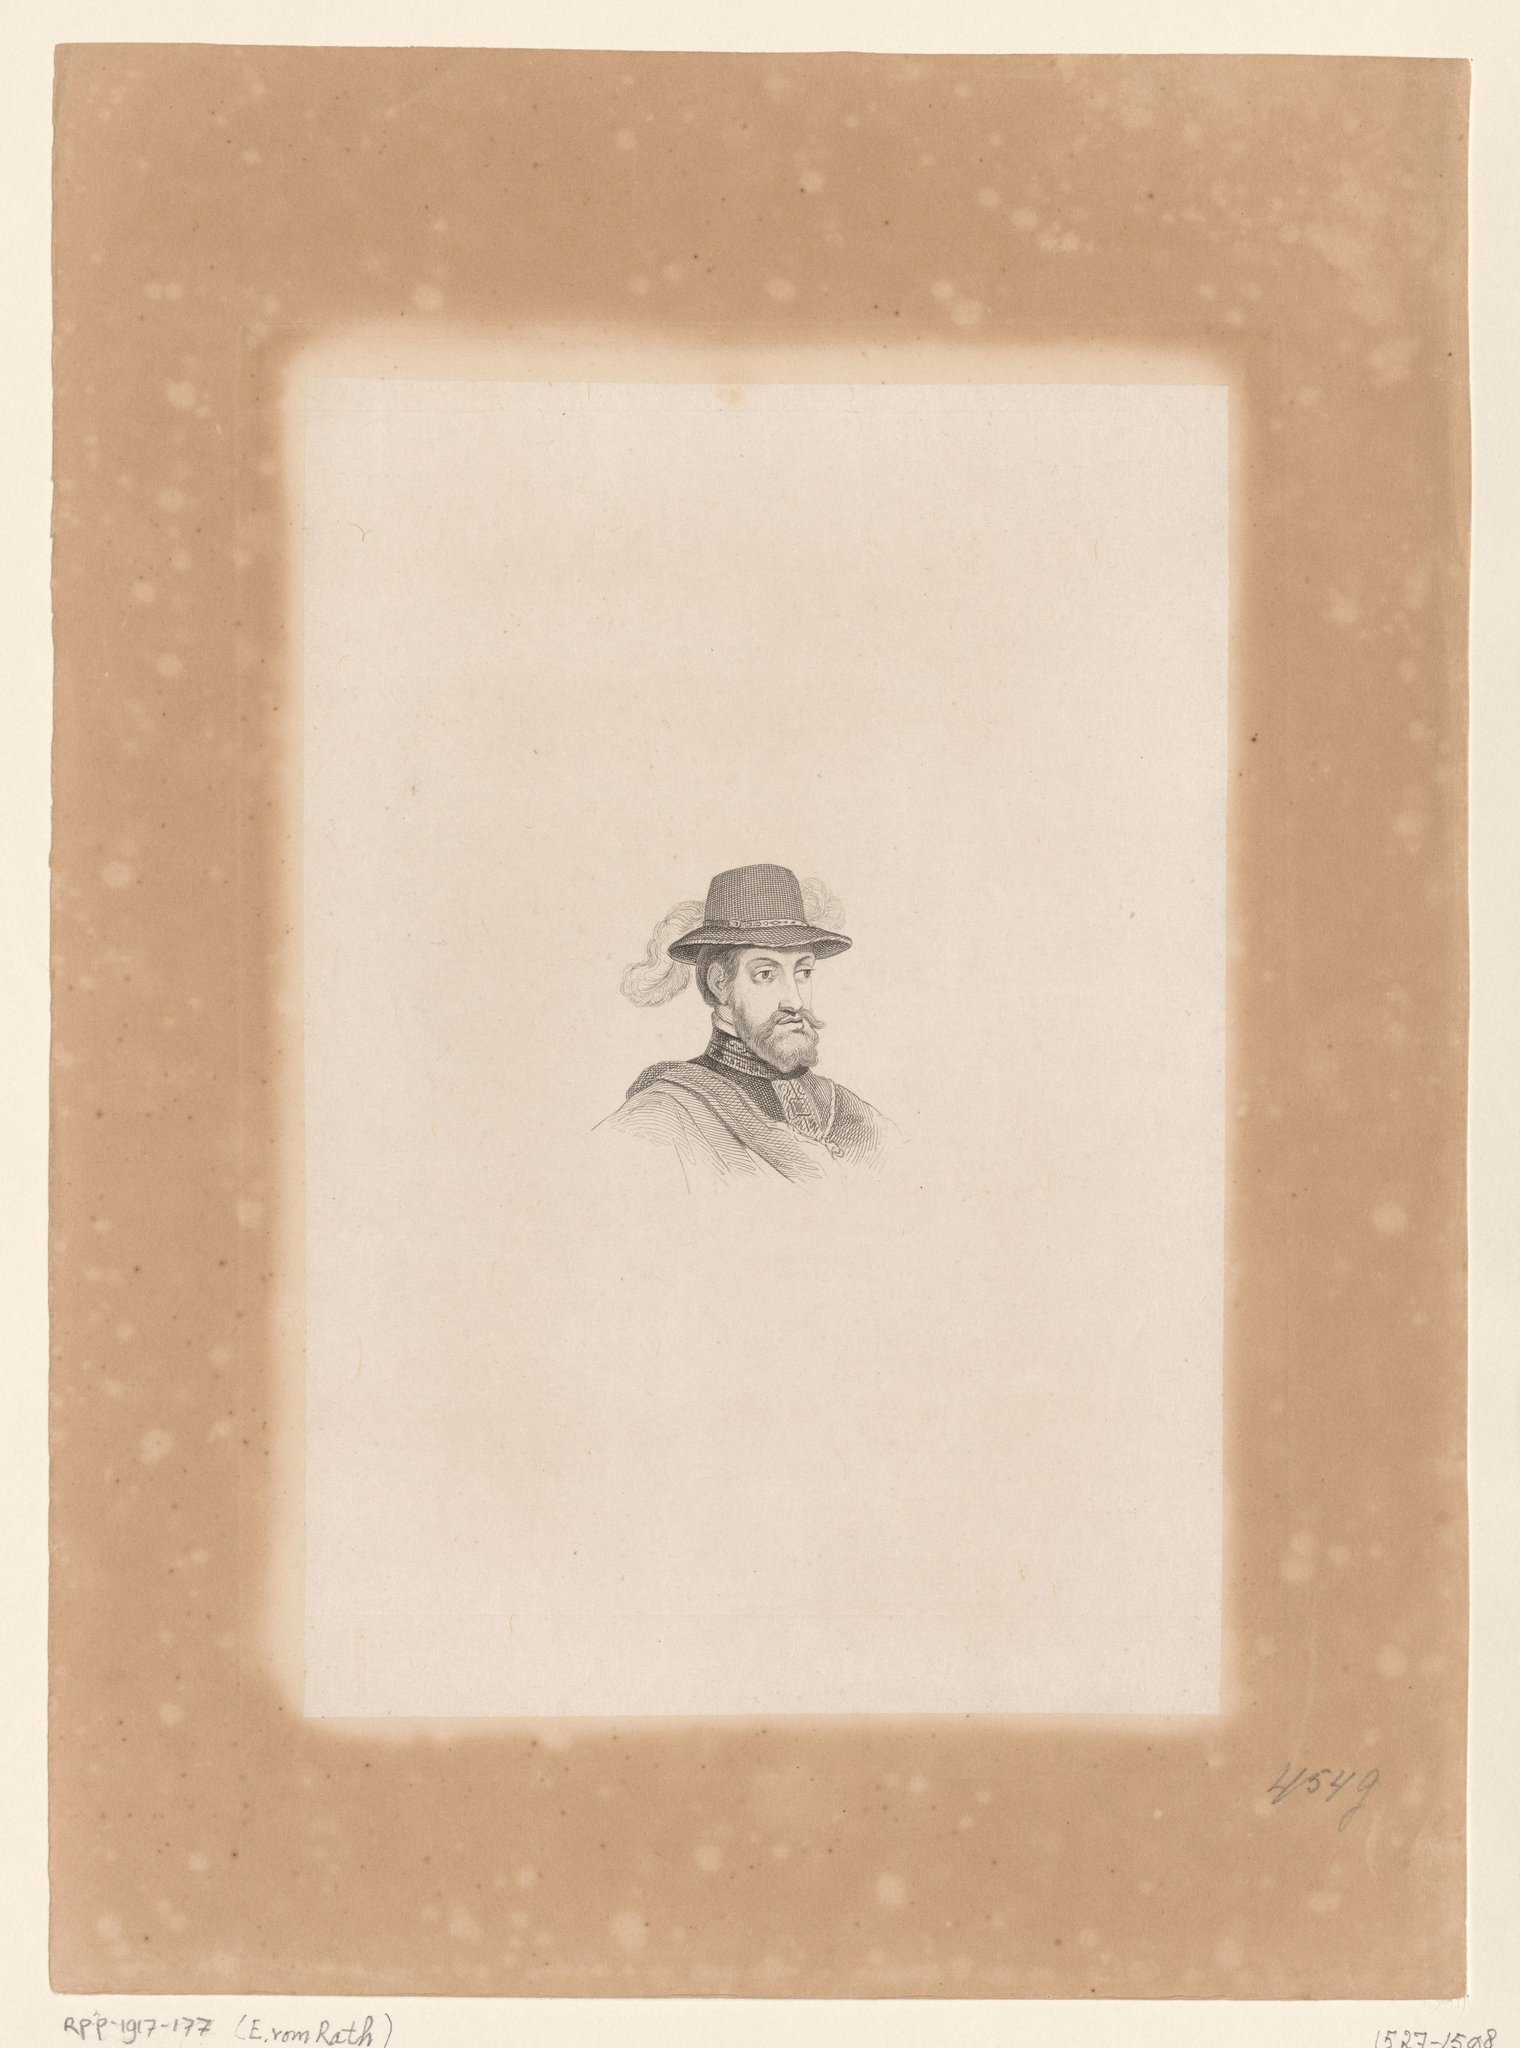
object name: print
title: Portret van Filips II, koning van Spanje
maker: Anonymous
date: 1700-1874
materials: paper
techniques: etching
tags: philip ii of spain, head-gear, adult man, historical persons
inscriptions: collector's mark: Lugt 2233